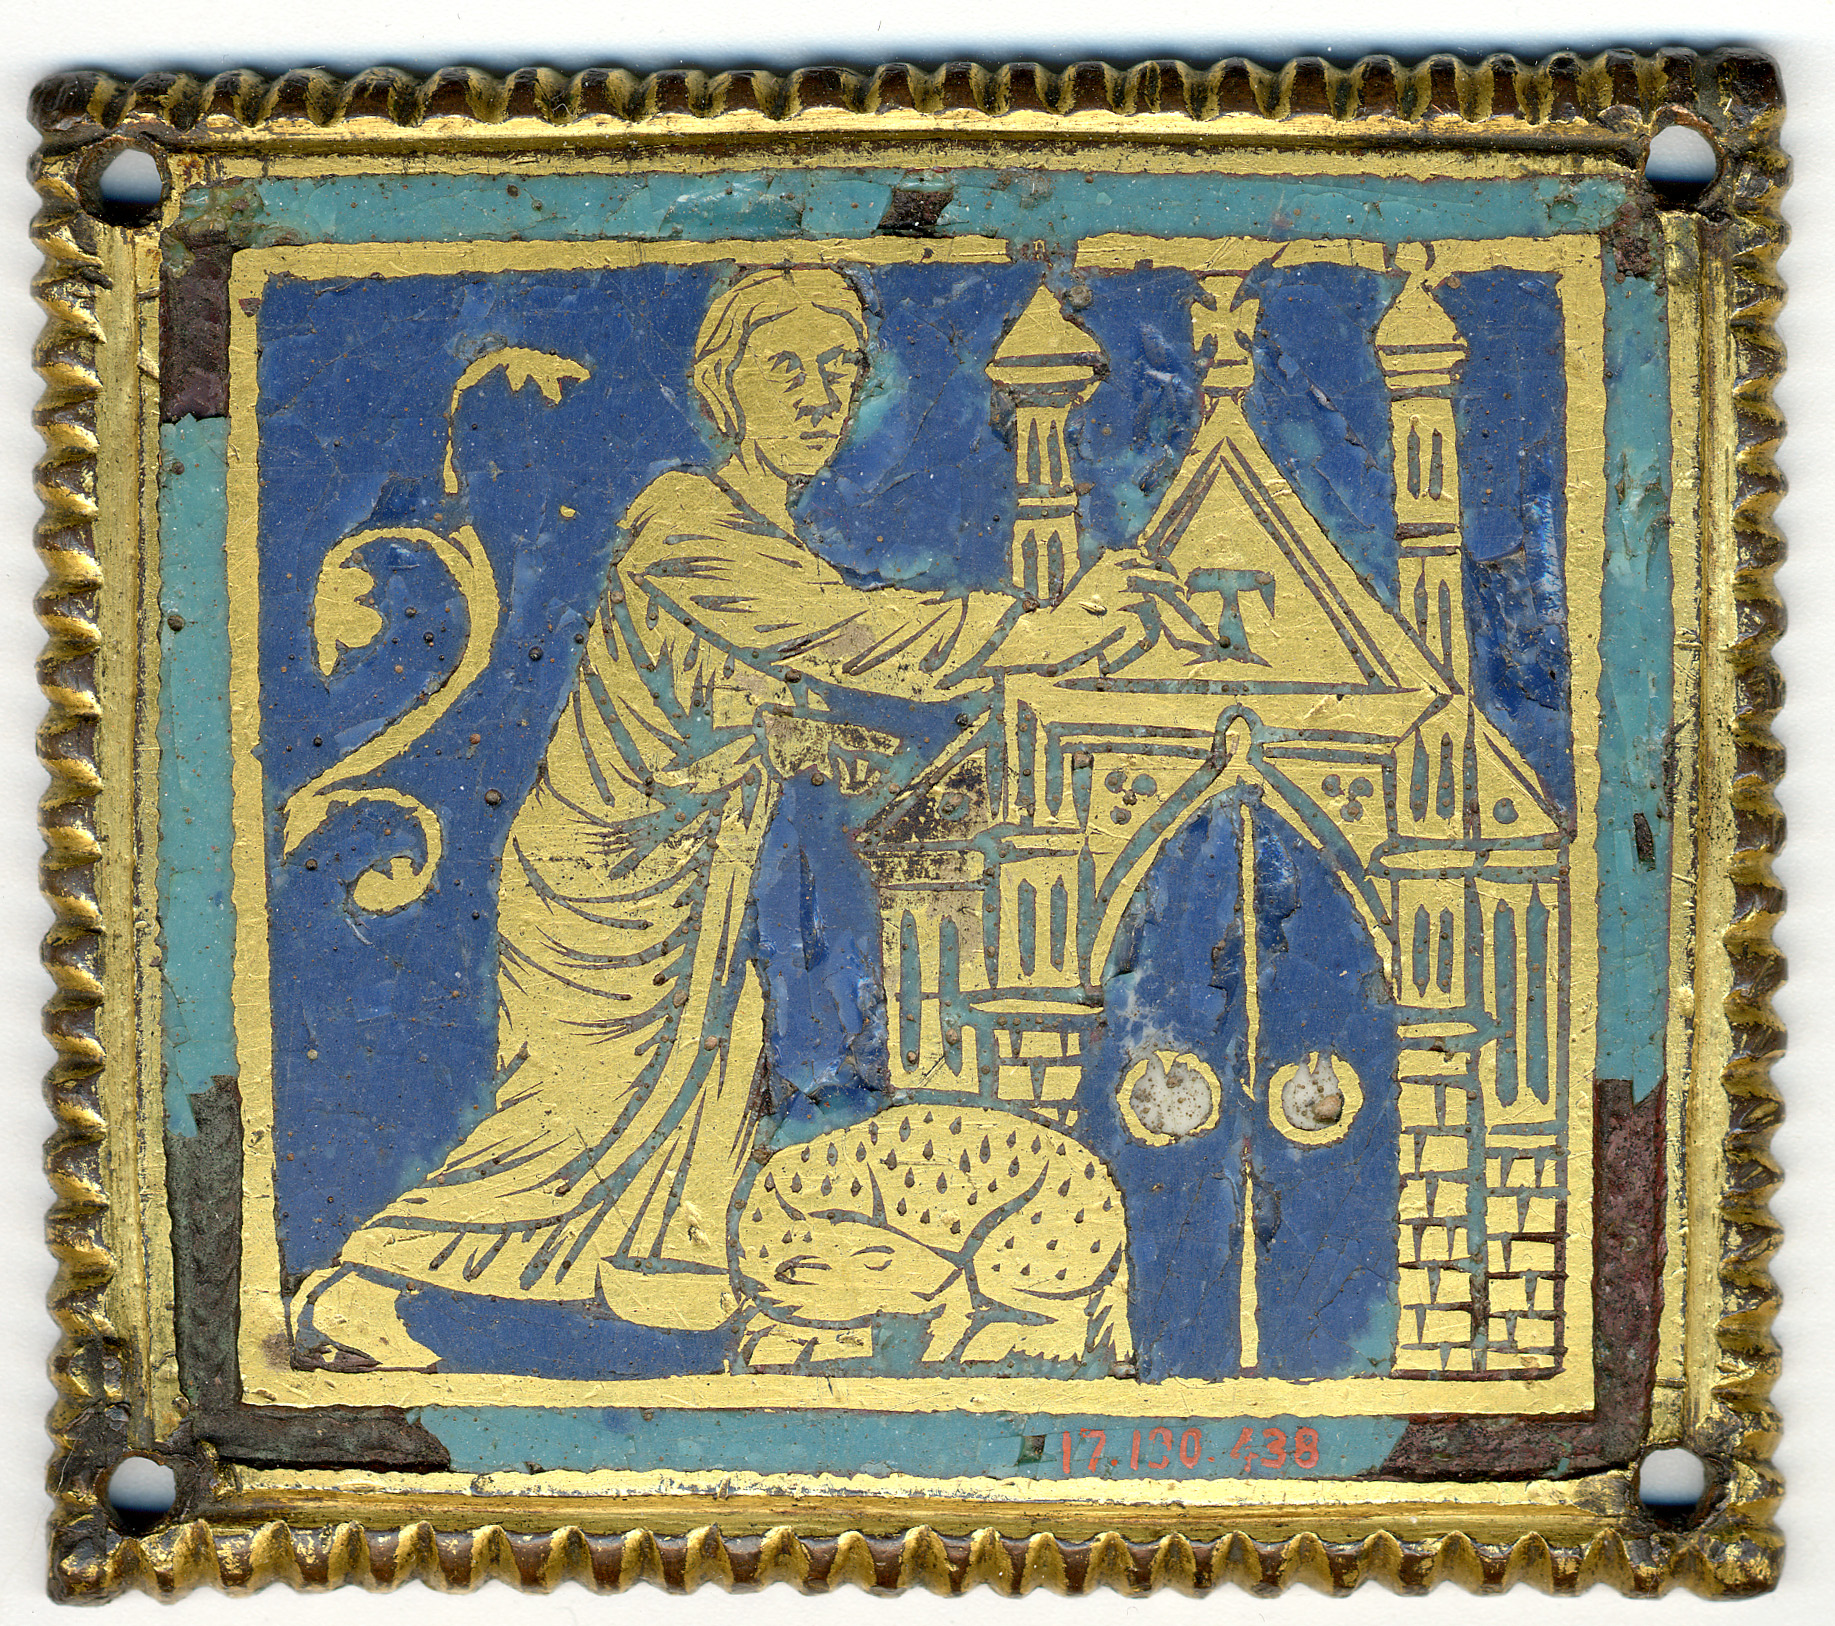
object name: plaque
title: Plaque with Marking of the Door with the Letter Tau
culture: german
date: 1200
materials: copper alloy, enamel, gilt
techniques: enamel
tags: men,cross,emblems